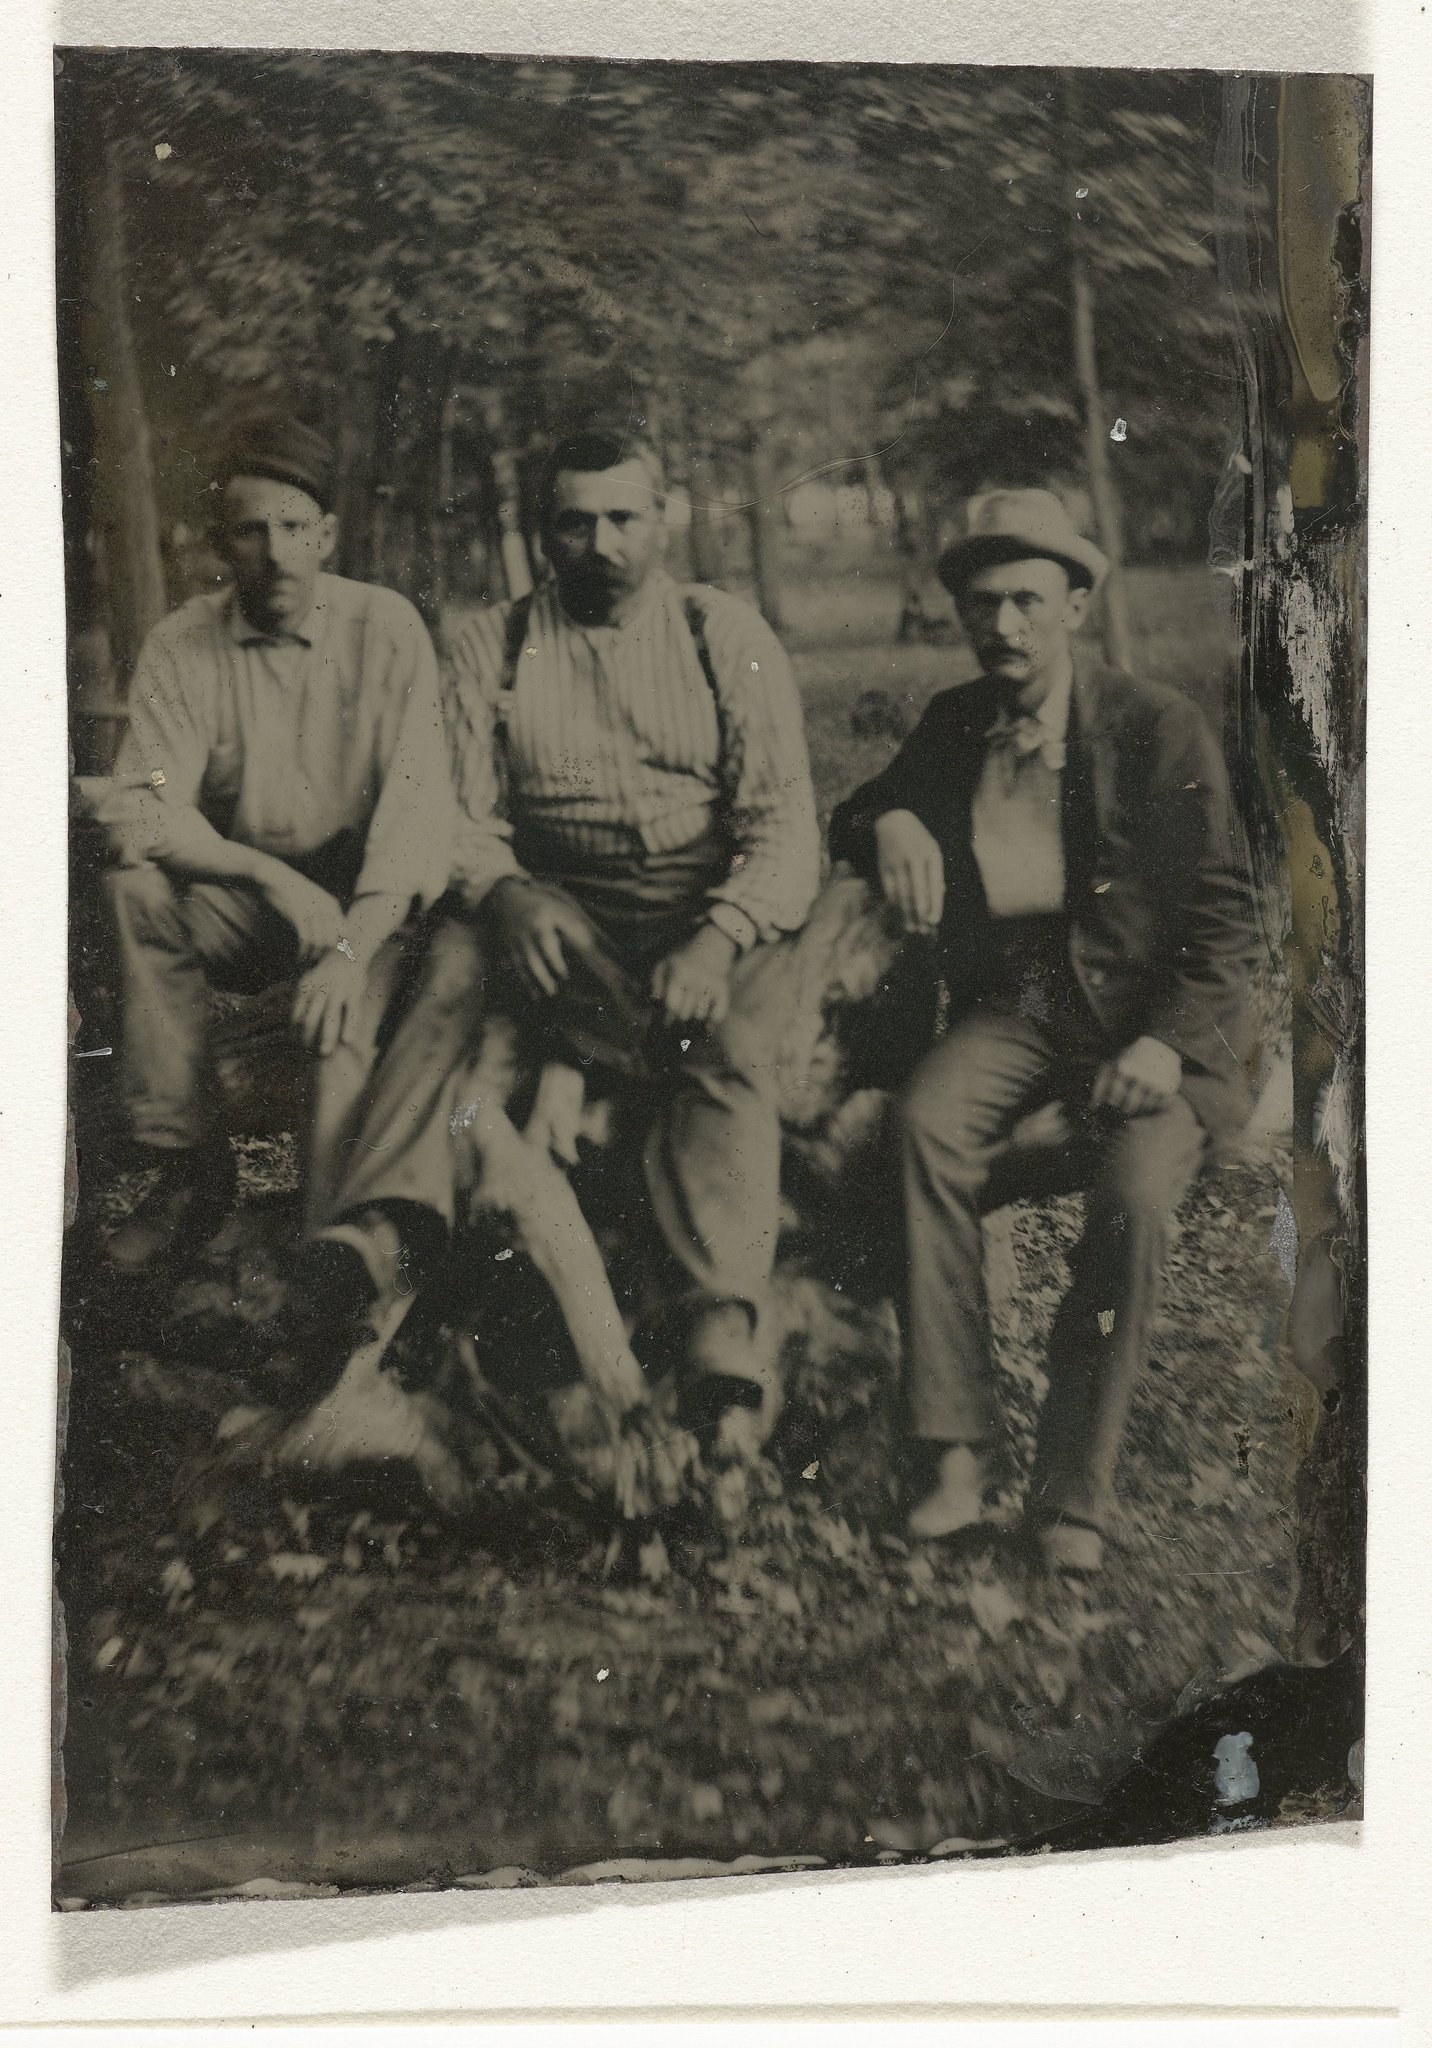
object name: photograph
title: Portret van drie mannen, zittend (op een boomstronk?) in een bos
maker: Anonymous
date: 1880-1900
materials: metal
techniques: ferrotyping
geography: united states